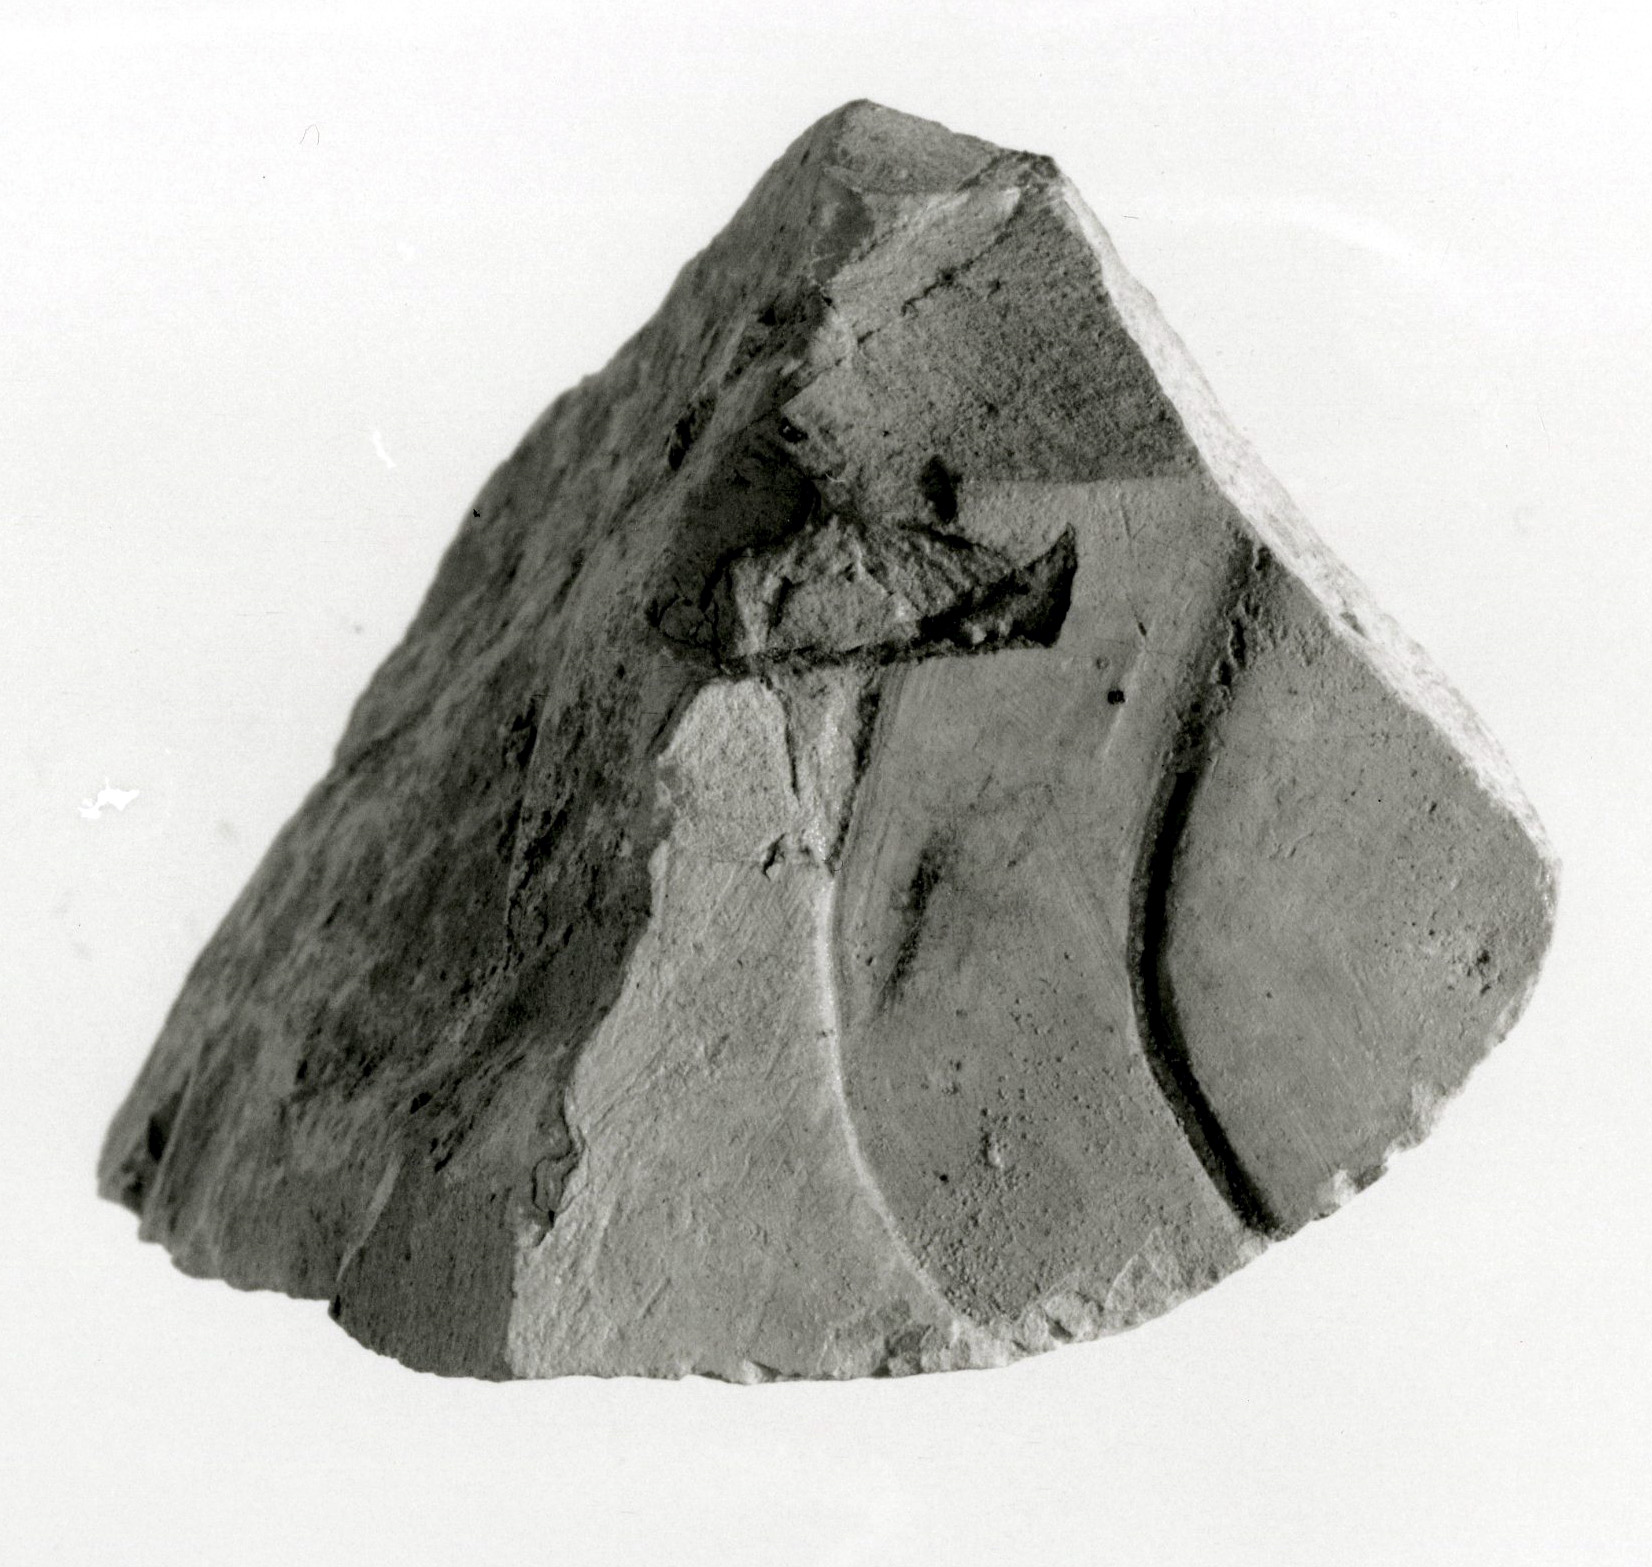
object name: relief, tomb of nespekashuty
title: Sunk relief fragment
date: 664-610 BCE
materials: limestone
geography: egypt